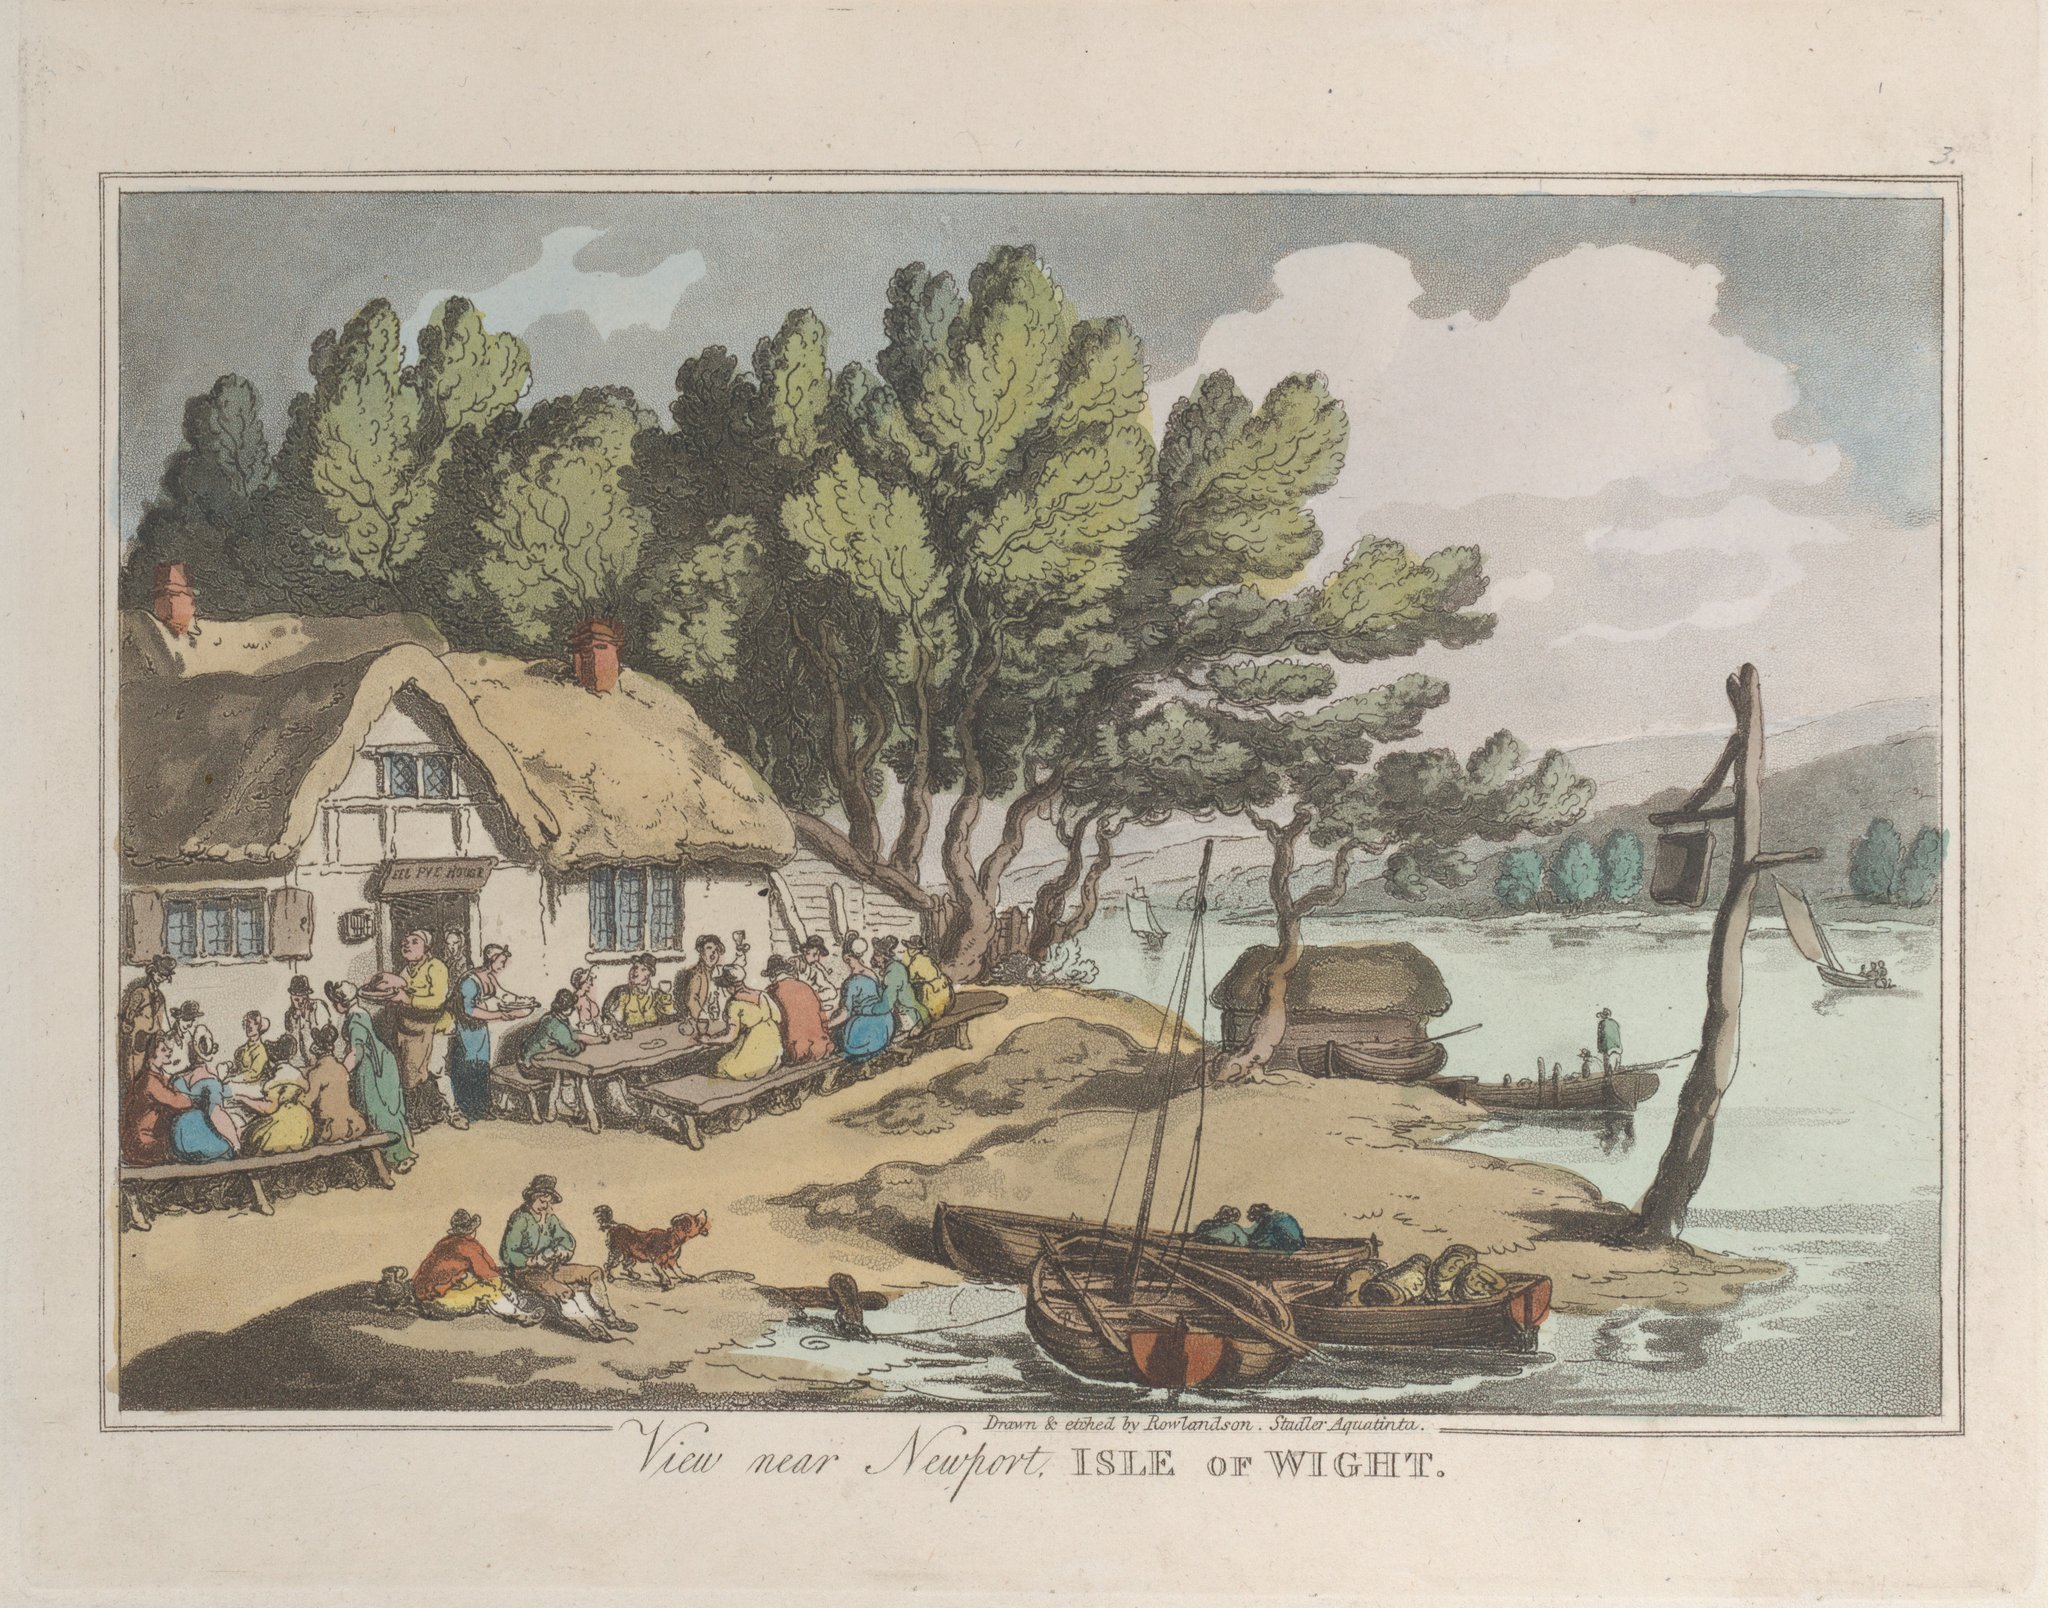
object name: print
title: View near Newport, Isle of Wight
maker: thomas rowlandson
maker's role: artist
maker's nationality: british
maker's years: 1757-1827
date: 1822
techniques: aquatint, etching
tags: rivers,dining,boats